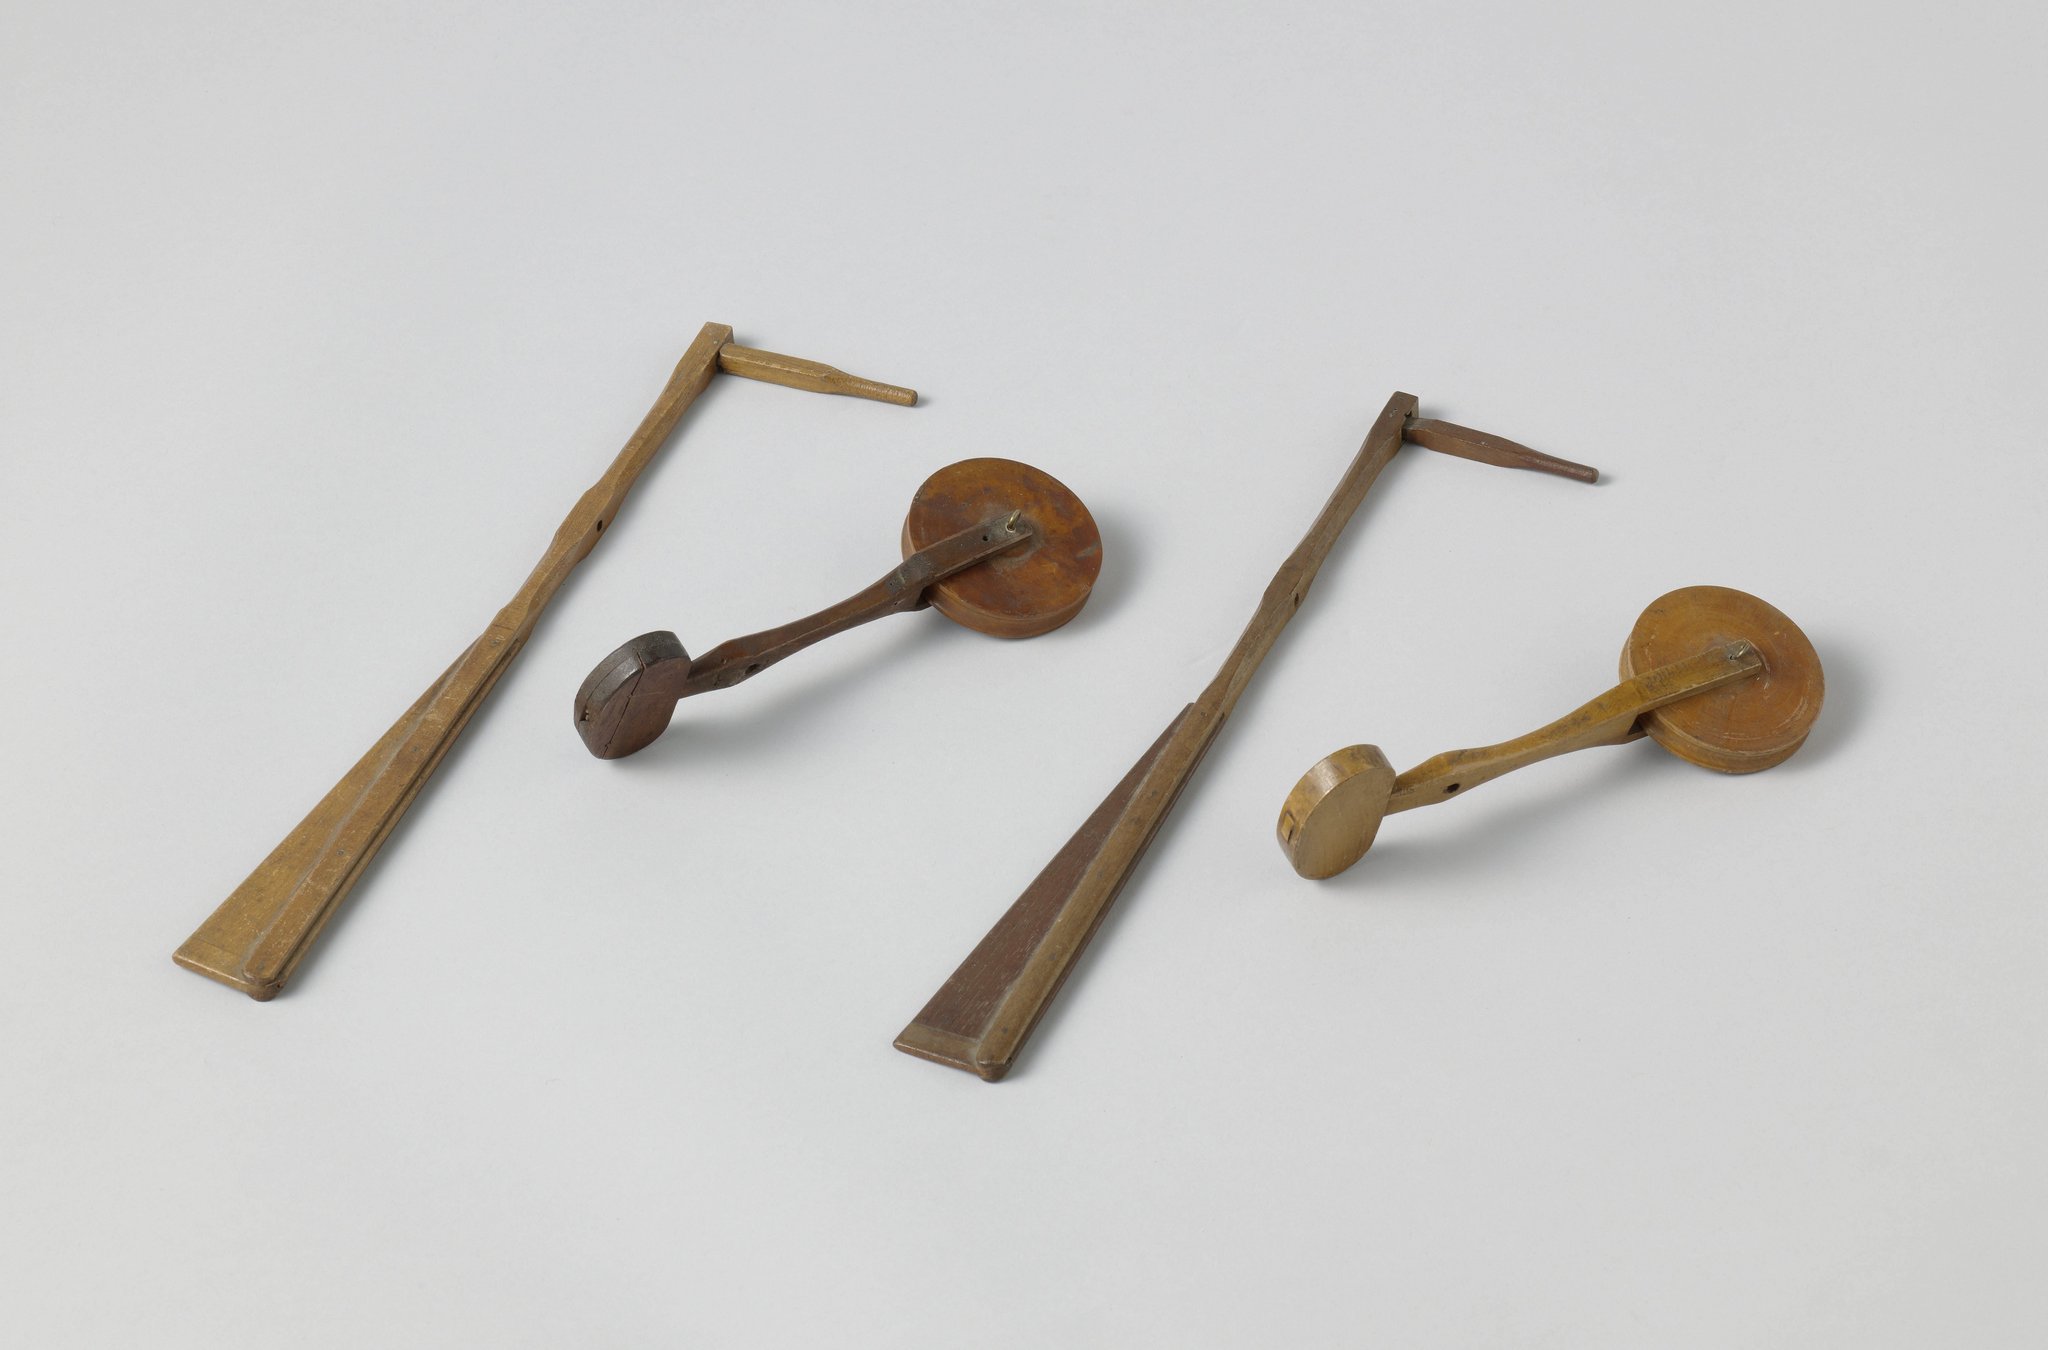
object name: demonstration model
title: Parts of a Model of a Rowing Mechanism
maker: jochem pietersz. asmus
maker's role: constructeur, directeur, equipagemeester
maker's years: 1755-1837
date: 1797-1810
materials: brass, wood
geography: amsterdam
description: Onderdelen van een zeer onvolledig model van een roei- of wrikwerktuig, bestaande uit twee paar identieke onderdelen. Het eerste paar zijn roeiriemen of roeren, met een gat in de standaard ter halver hoogte, en een soort helmstok die verticaal kan bewegen. De andere onderdelen bestaan uit een gevorkt stuk hout met in de vork een grote schijf, en aan het andere eind een niervormig stuk hout; ook dit onderdeel heeft in het midden een gat. Dit inventarisnummer bevatte oorspronkelijk ook enige modellen van masten, rondhouten, zalings en ezelshoofden, die niet zijn teruggevonden. De onderdelen van het roeiwerktuig zijn apart en zonder inventarisnummer aangetroffen, zodat de identificatie louter op veronderstelling berust. De onderdelen vormen echter wel duidelijk twee paren en zijn van hetzelfde maaksel.